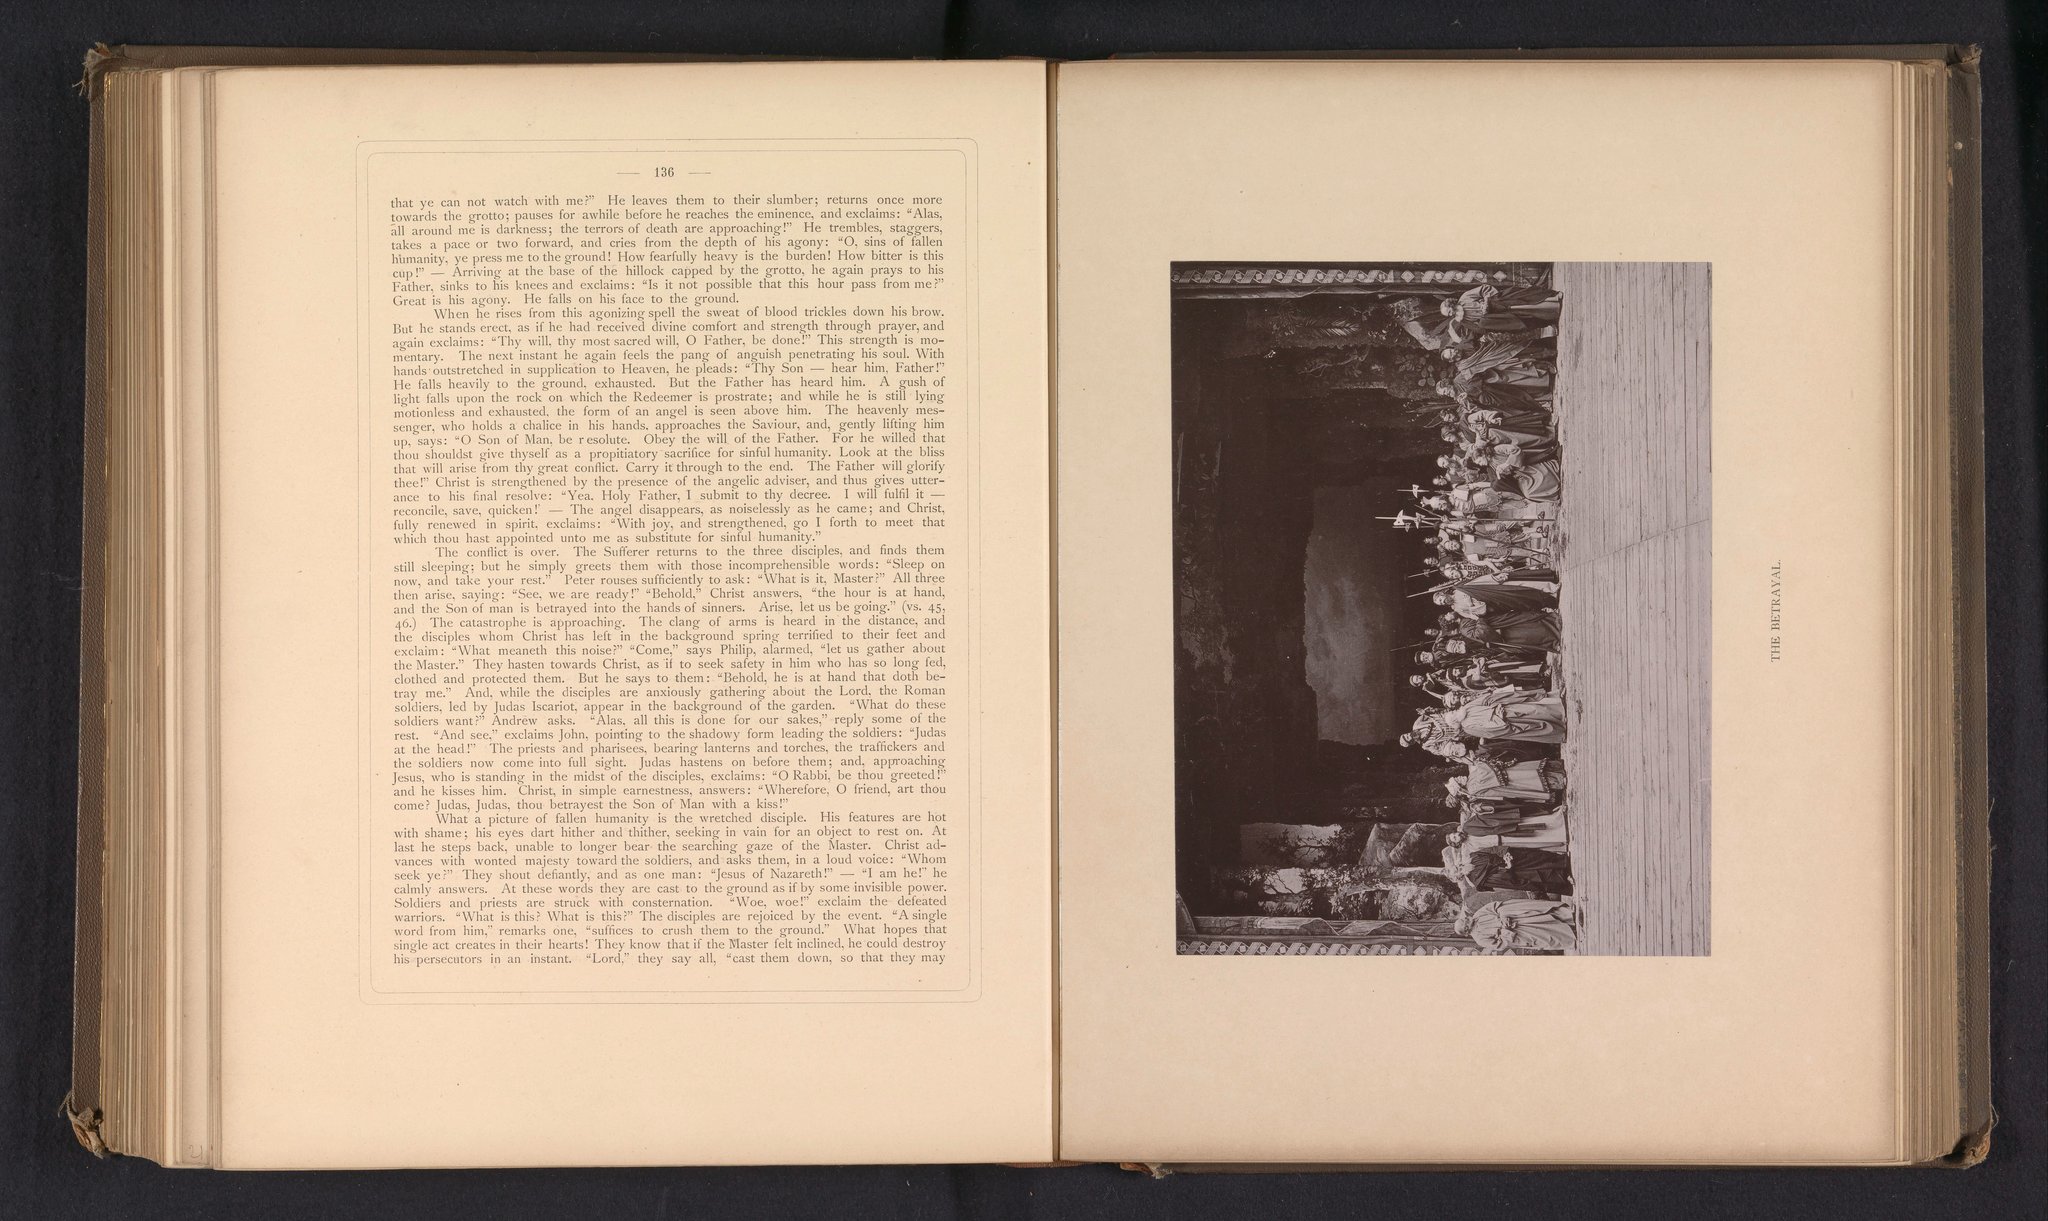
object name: photomechanical print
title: The betrayal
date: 1885-1890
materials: paper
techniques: photograph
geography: oberammergau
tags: the kiss of judas: accompanied by soldiers with torches and lanterns, he kisses christ, group of actors, troupe; actors on the stage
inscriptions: inscription: ‘Gemeinde Oberammergau Passionsspiel 1890’